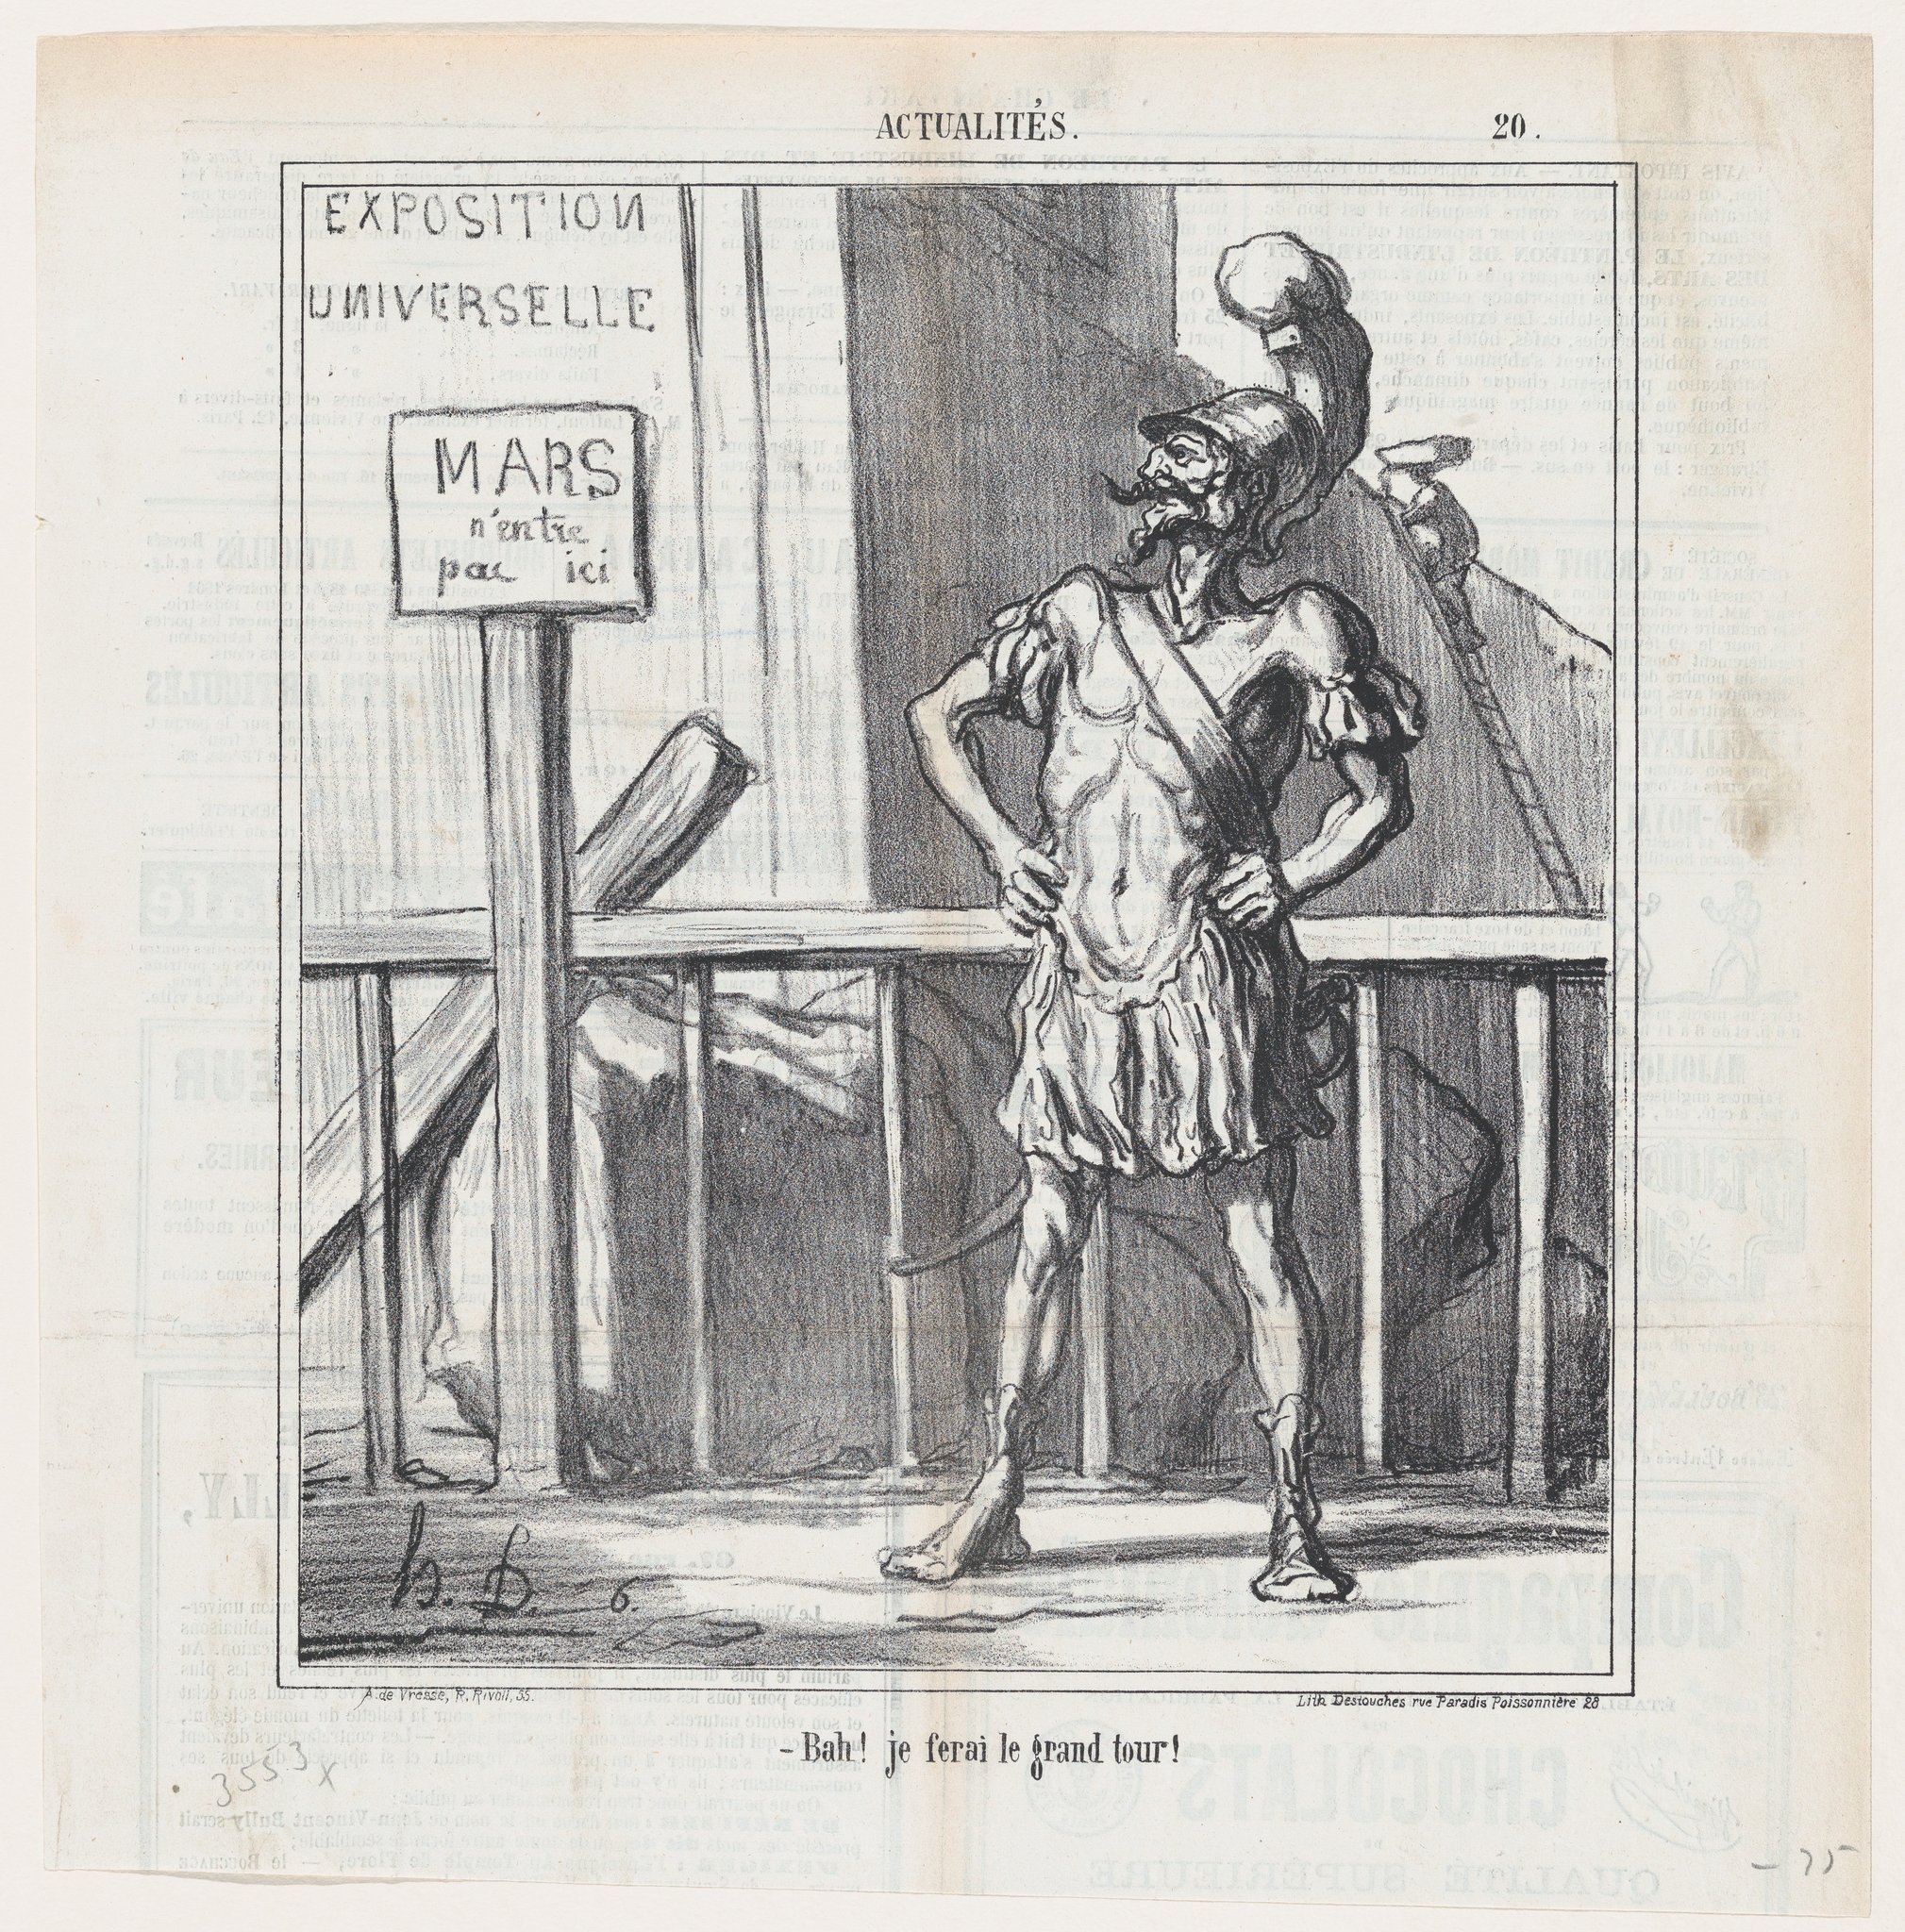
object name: print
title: Bah! I will make a grand tour!, from "News of the day"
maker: honoré daumier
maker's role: artist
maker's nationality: french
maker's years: 1808-1879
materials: paper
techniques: lithograph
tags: men